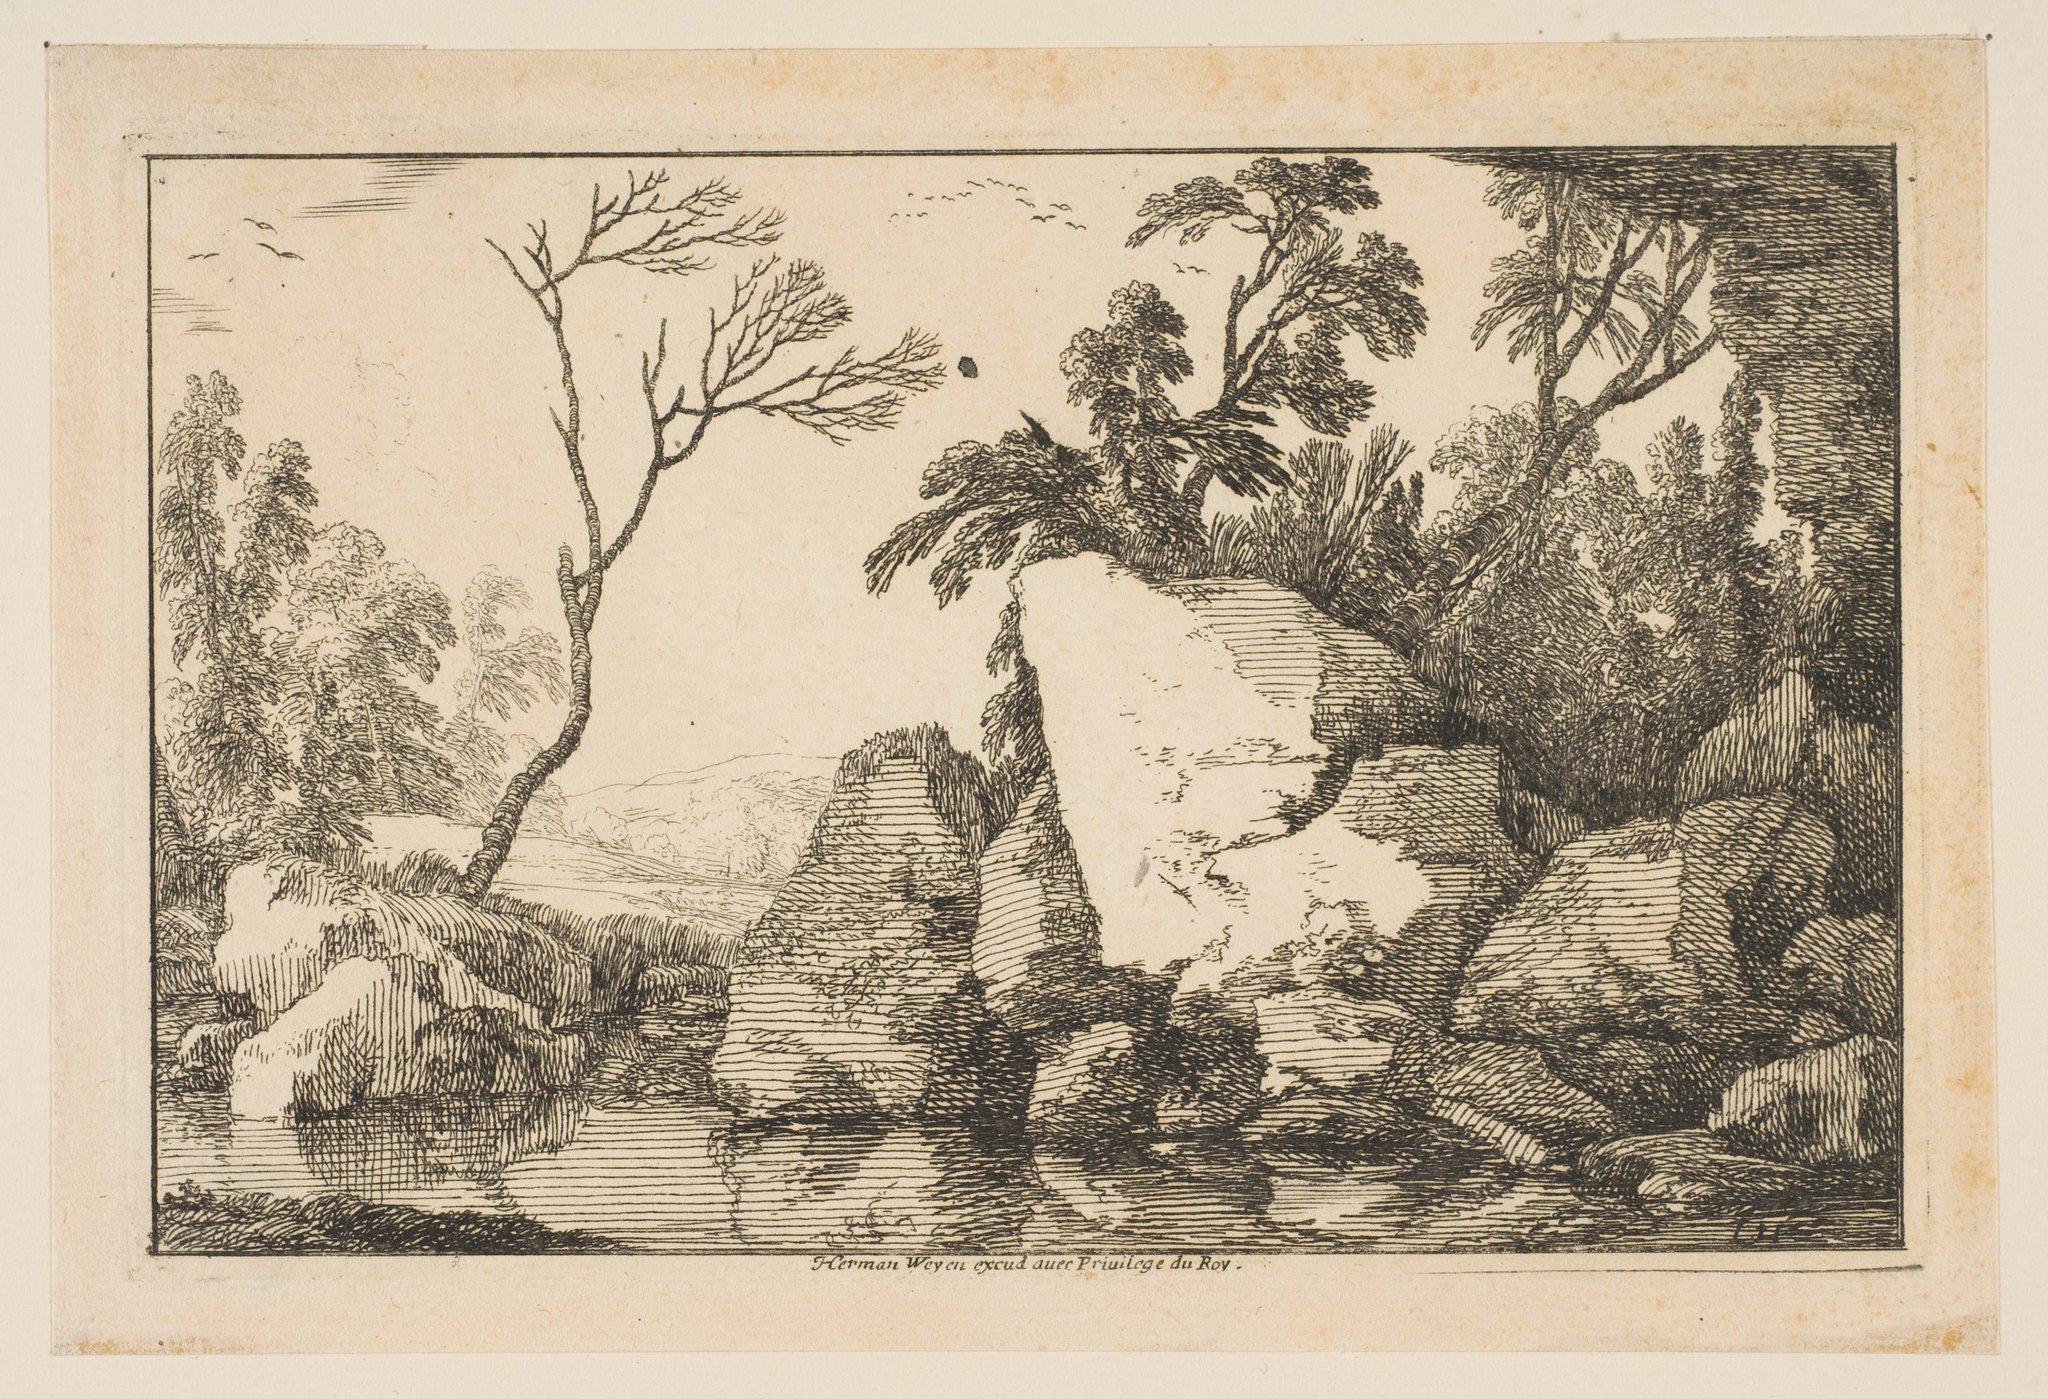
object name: print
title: The Dead Tree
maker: laurent de la hyre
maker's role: artist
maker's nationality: french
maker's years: 1606-1656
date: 1640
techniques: etching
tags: trees